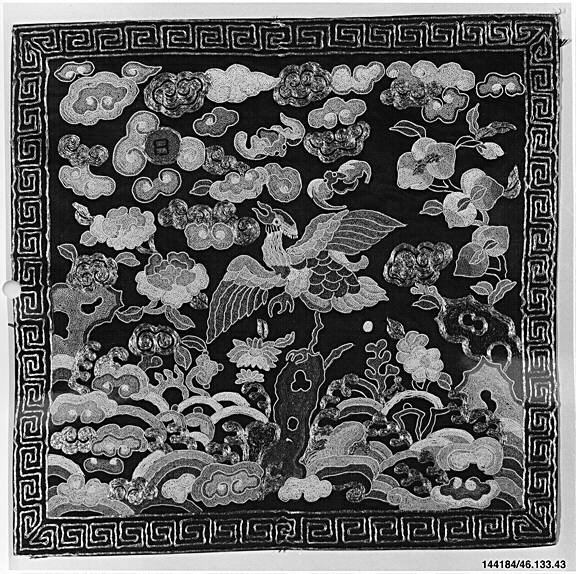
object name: rank badge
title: Rank Badge with Mandarin Duck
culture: chinese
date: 1767-1800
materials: metal thread, silk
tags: bats,ducks